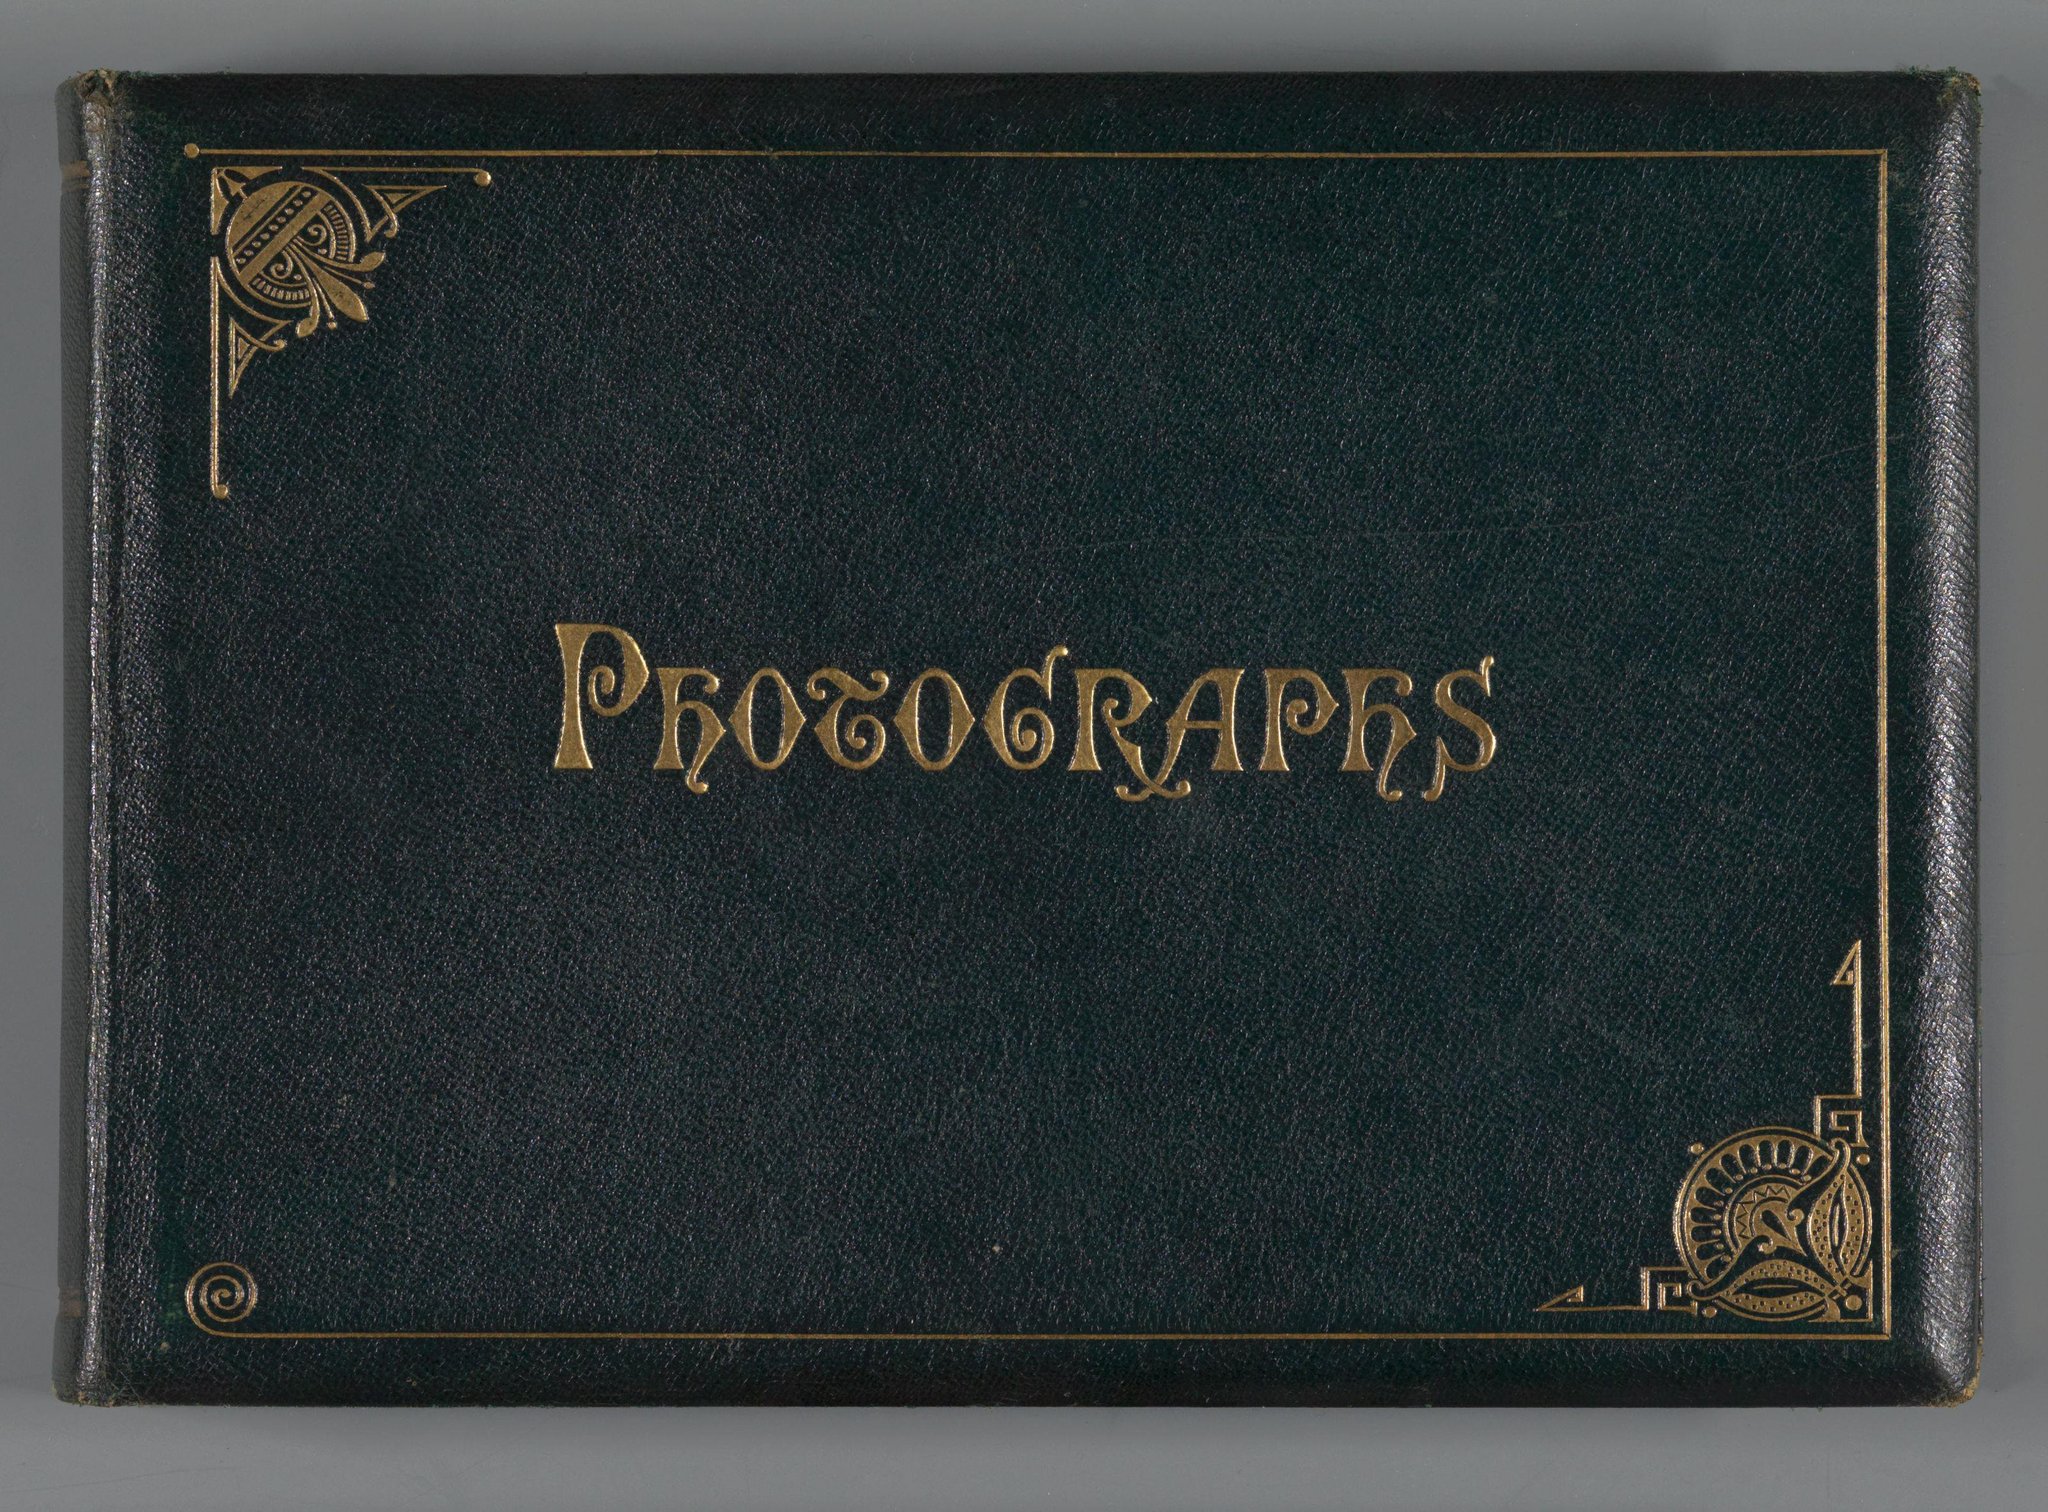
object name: photograph album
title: Fotoalbum met bezienswaardigheden in Edinburgh en Londen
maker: Anonymous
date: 1860-1900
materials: cardboard, leather, paper, photographic support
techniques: albumen print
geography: great britain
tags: travelling; tourism, prospect of city, town panorama, silhouette of city, london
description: Fotoalbum in zwarte leren band met op het voorplat de titel in gouddruk en in reliëf. De hoekpunten zijn versierd met geometrische motieven, eveneens in reliëf en gouddruk. De schutbladen zijn van changeant papier. Het album bevat 10 bladen goud op snee met daartussen papieren scheidingsvellen. Het betreft voornamelijk opnames van bezienswaardigheden in Edinburgh waaronder panoramische stadsgezichten, universiteitsgebouwen, de Old Town, Edinburgh Castle en Holyrood Palace, Dean Bridge en Waverley Bridge en de Royal Infirmary. De laatste zeven foto's in het album zijn afdrukken van bekende kerken en gebouwen in Londen zoals Westminster Abbey, Saint Paul's Cathedral, de Tower en de Royal Courts of Justice.